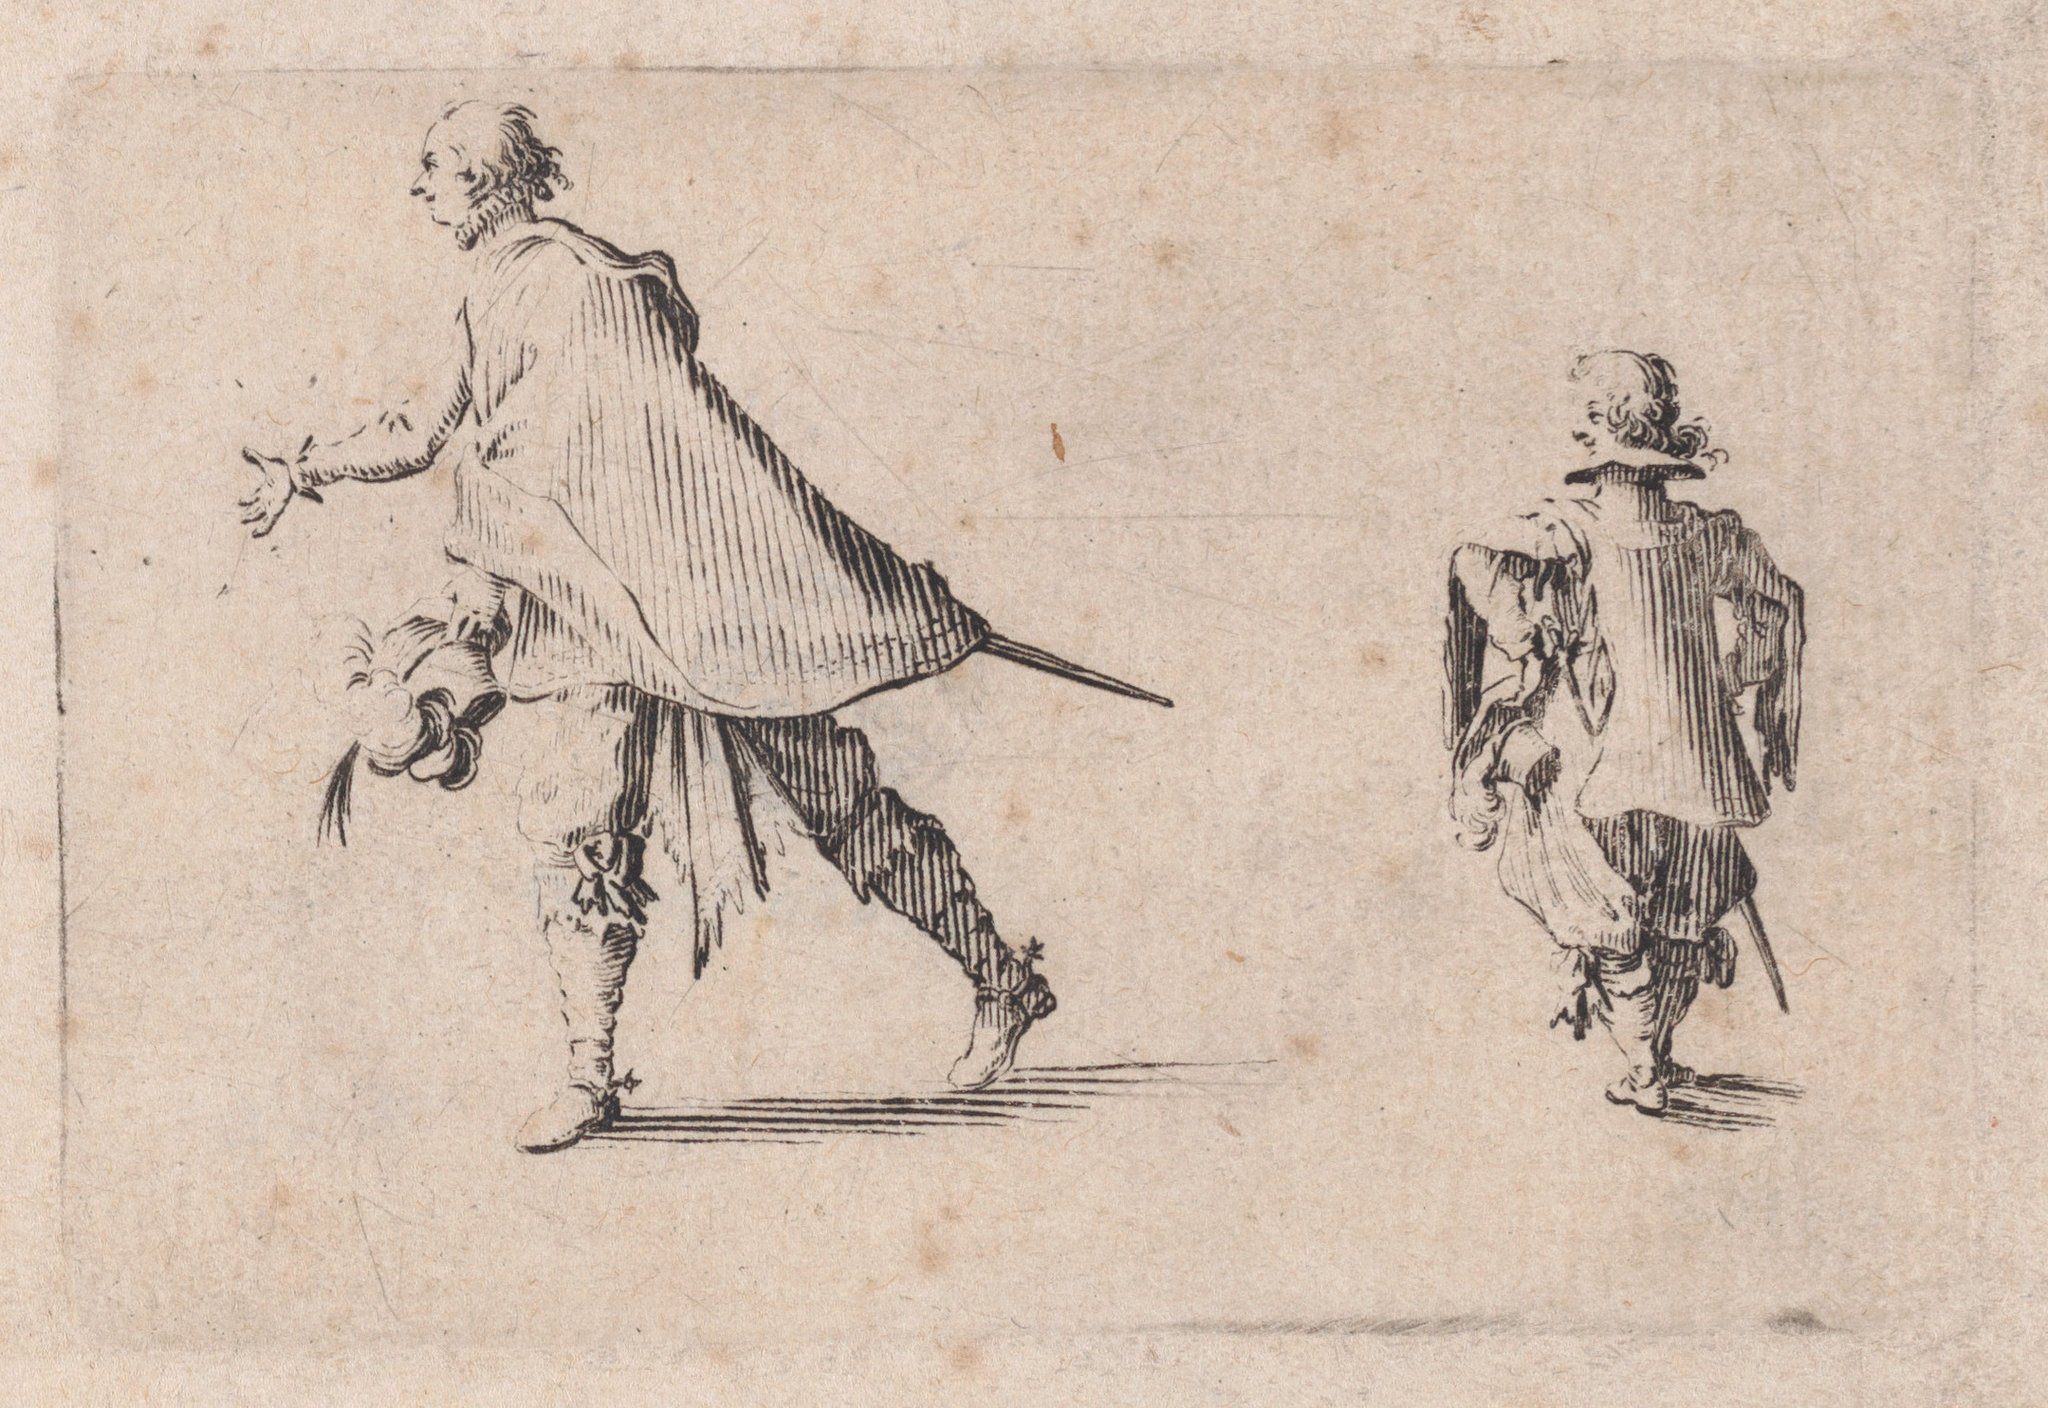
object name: print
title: Un Gentilhomme et Son Page (A Gentleman and his Page), from "Les Caprices" Series B, The Nancy Set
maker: jacques callot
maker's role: artist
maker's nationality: french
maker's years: 1592-1635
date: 1617-1620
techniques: etching